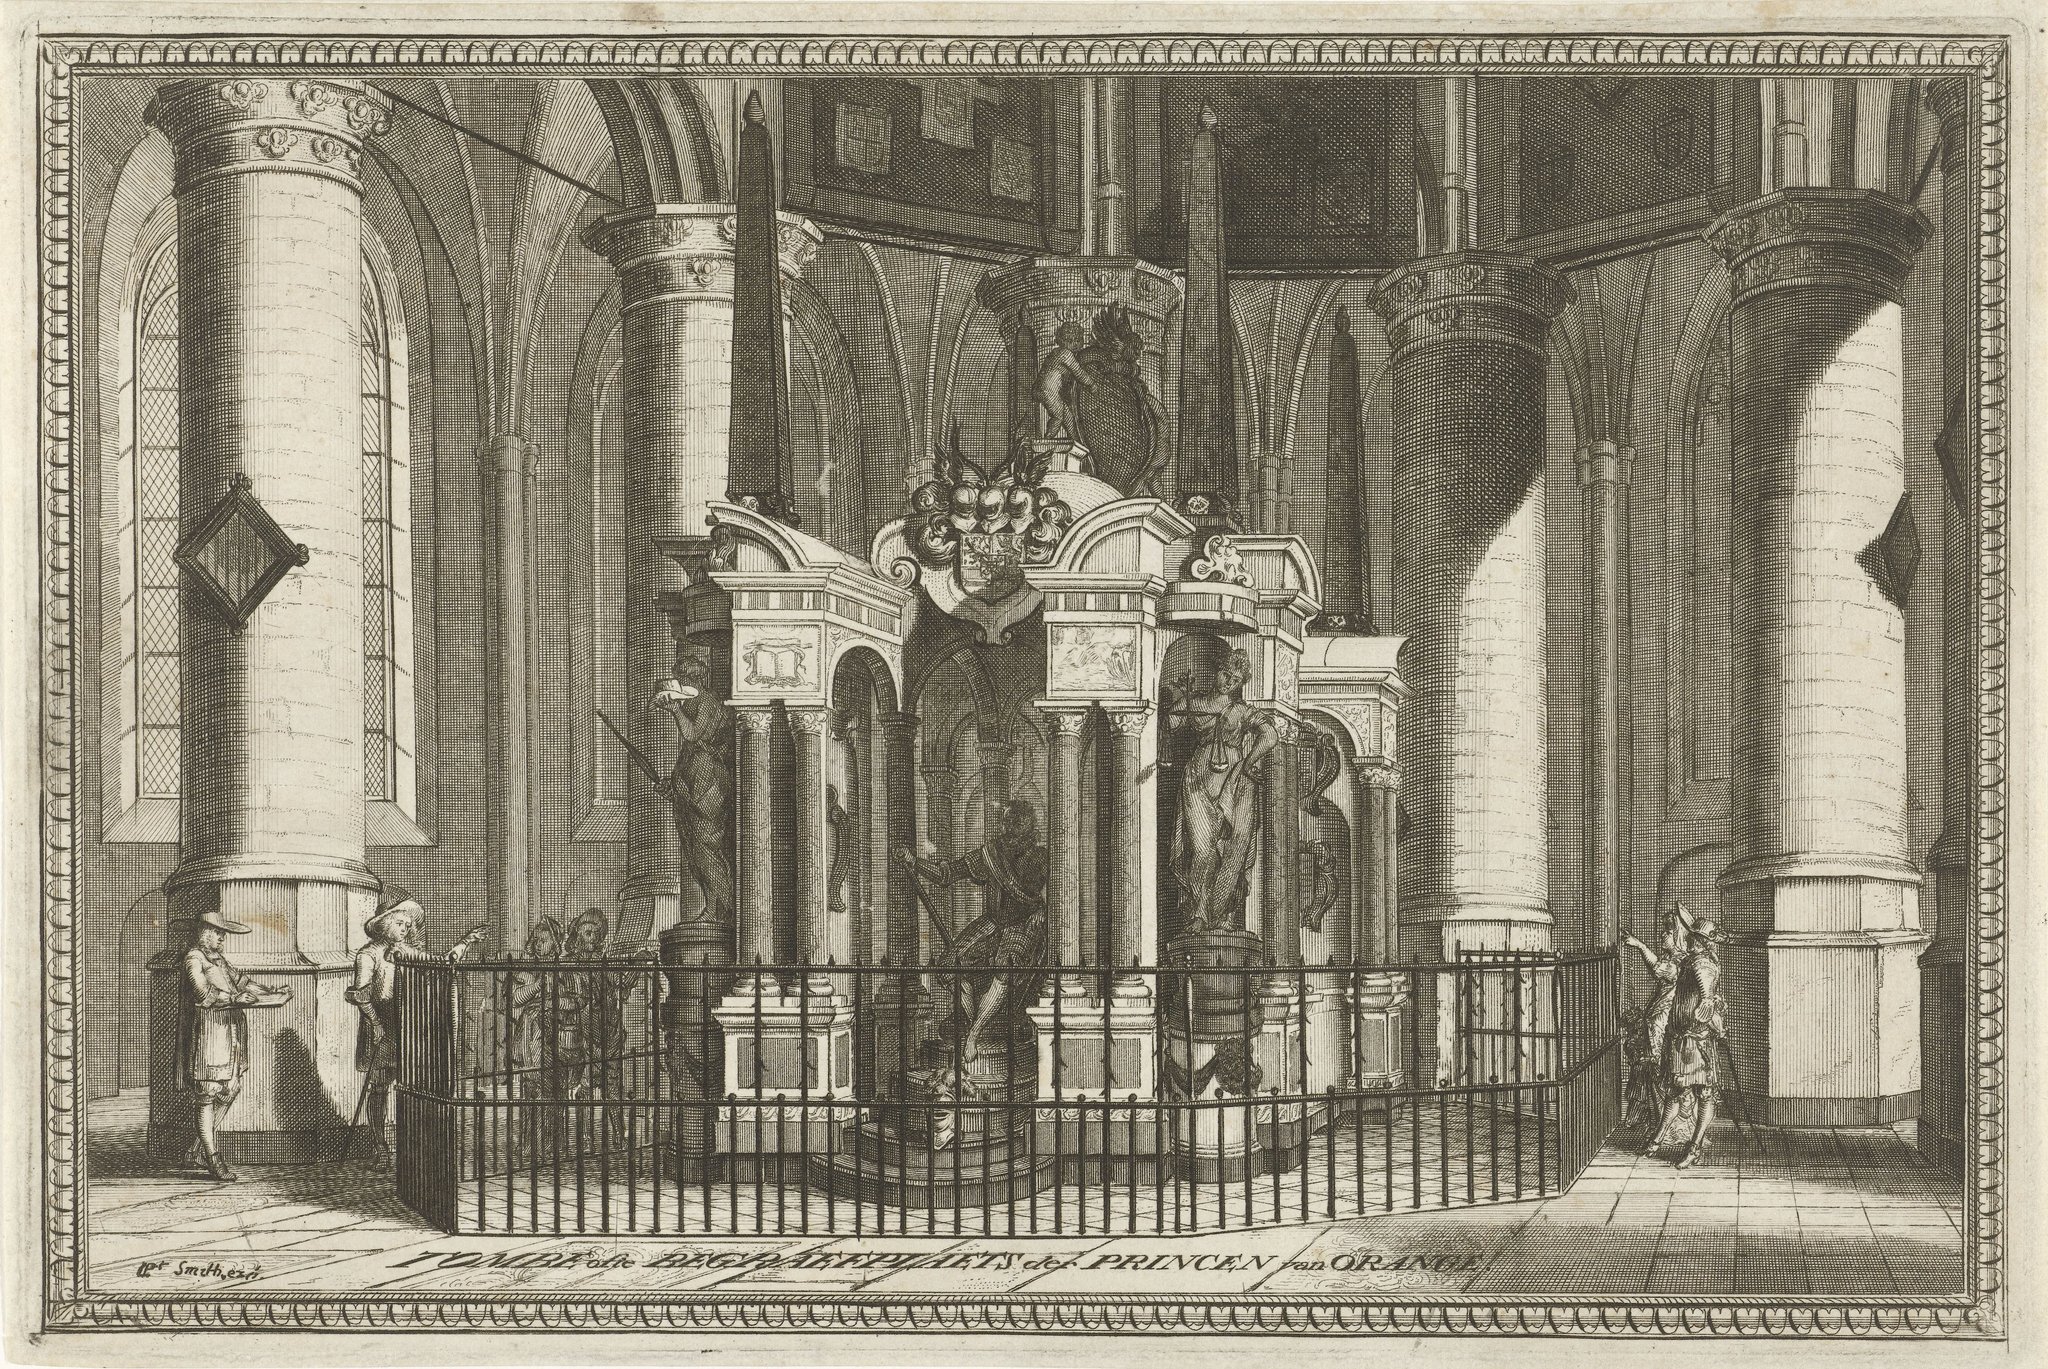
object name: historical object representation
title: Tombe ofte Begraefplaets der Princen van Orange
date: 1700-1799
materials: paper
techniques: etching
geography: netherlands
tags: delft, william i (prince of orange), grave-building, monumental tomb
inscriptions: inscription: ‘Franken No. 84’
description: Graftombe of praalgraf van Willem I in de Nieuwe Kerk te Delft, voltooid in 1623. Met de omlijsting.